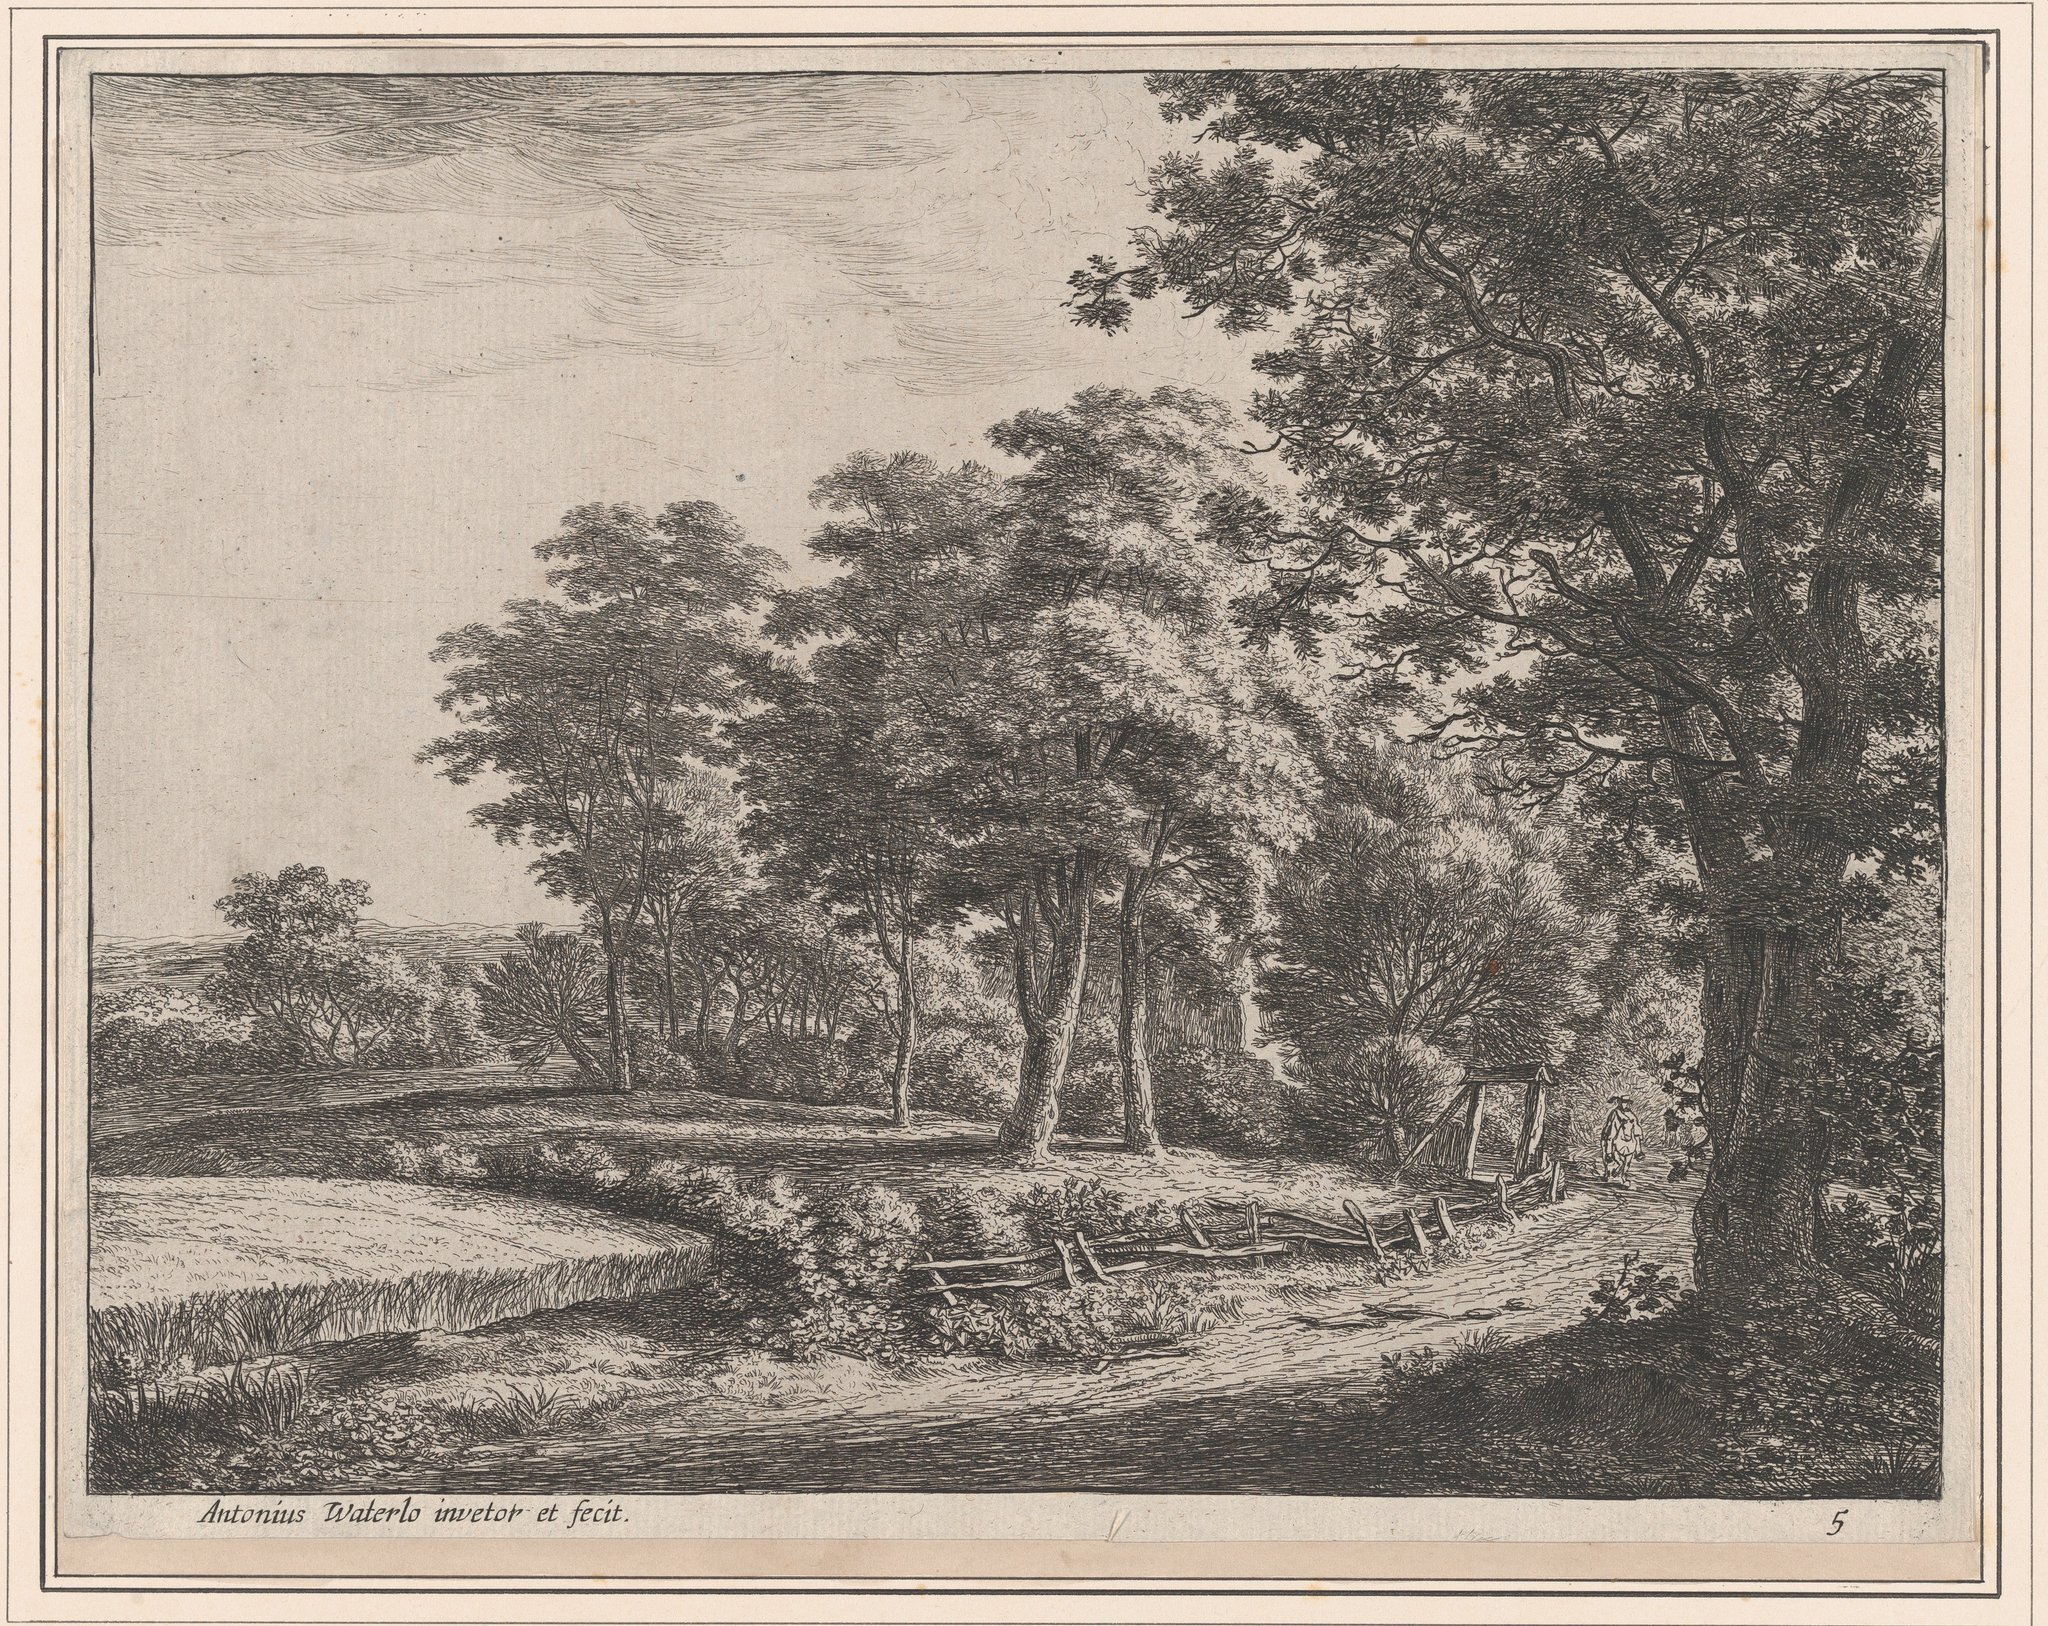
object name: print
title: A Horseman by a Fence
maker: anthonie waterloo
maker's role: artist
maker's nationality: dutch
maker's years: 1609-1690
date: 1601-1700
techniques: etching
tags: landscapes